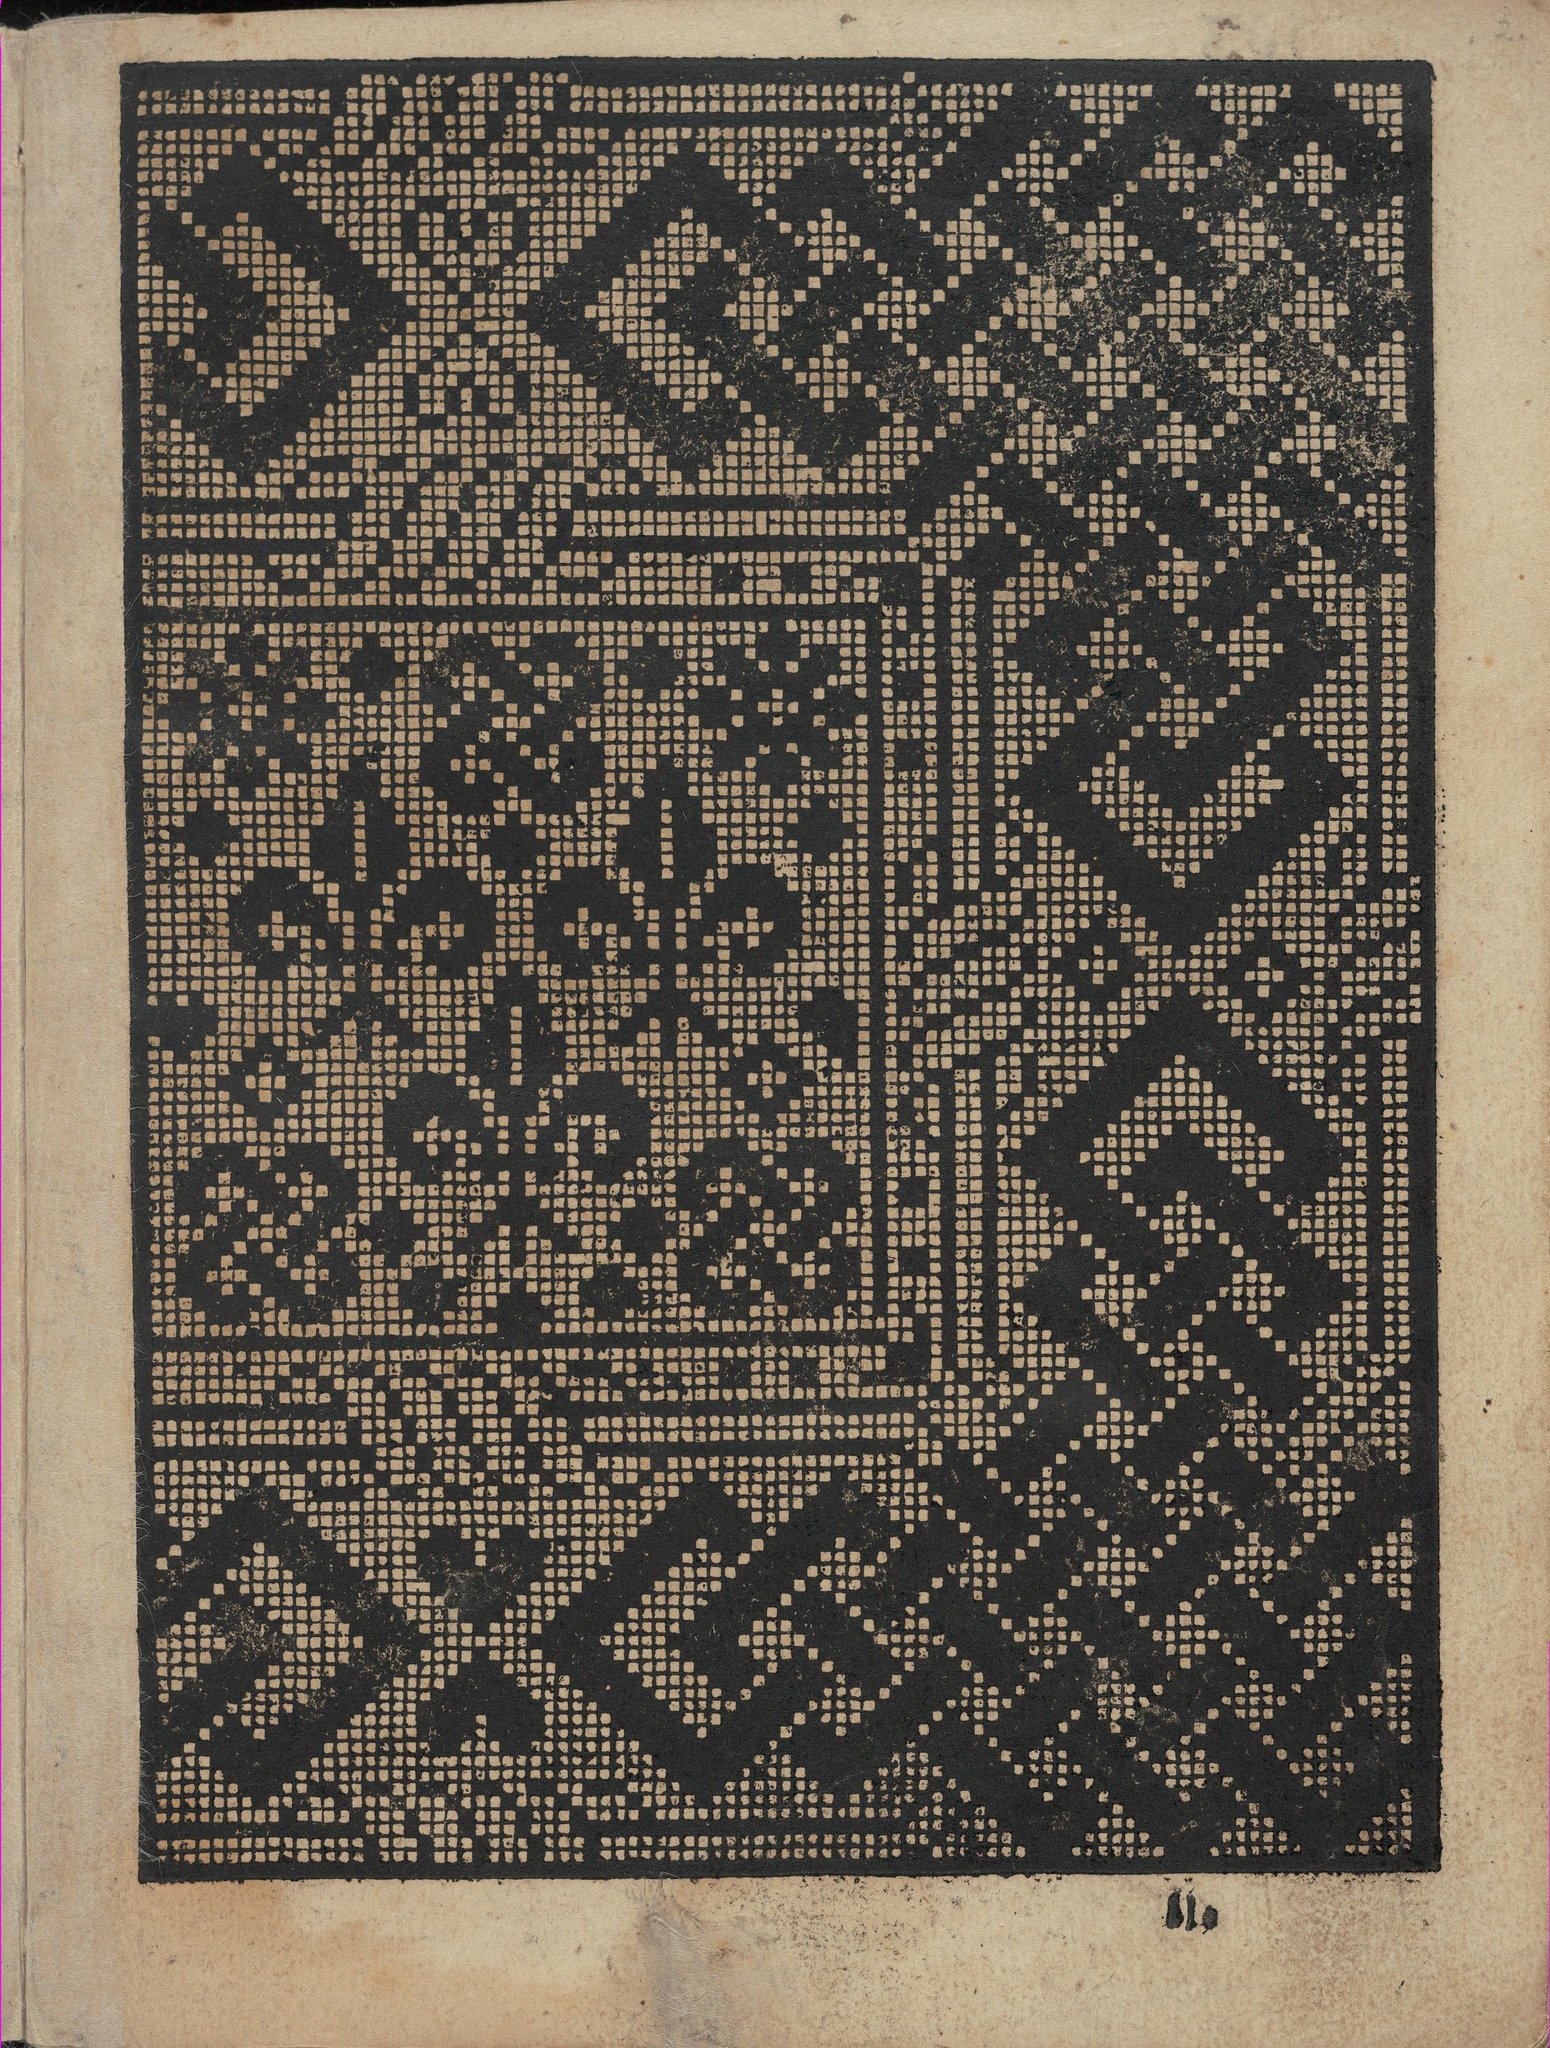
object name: book print ornament architecture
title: Libbretto nouellamete composto per maestro Domenico da Sera...lauorare di ogni sorte di punti, page 2 (recto)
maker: domenico da sera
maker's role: publisher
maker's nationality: french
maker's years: 1500-1599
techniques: woodcut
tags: ornament